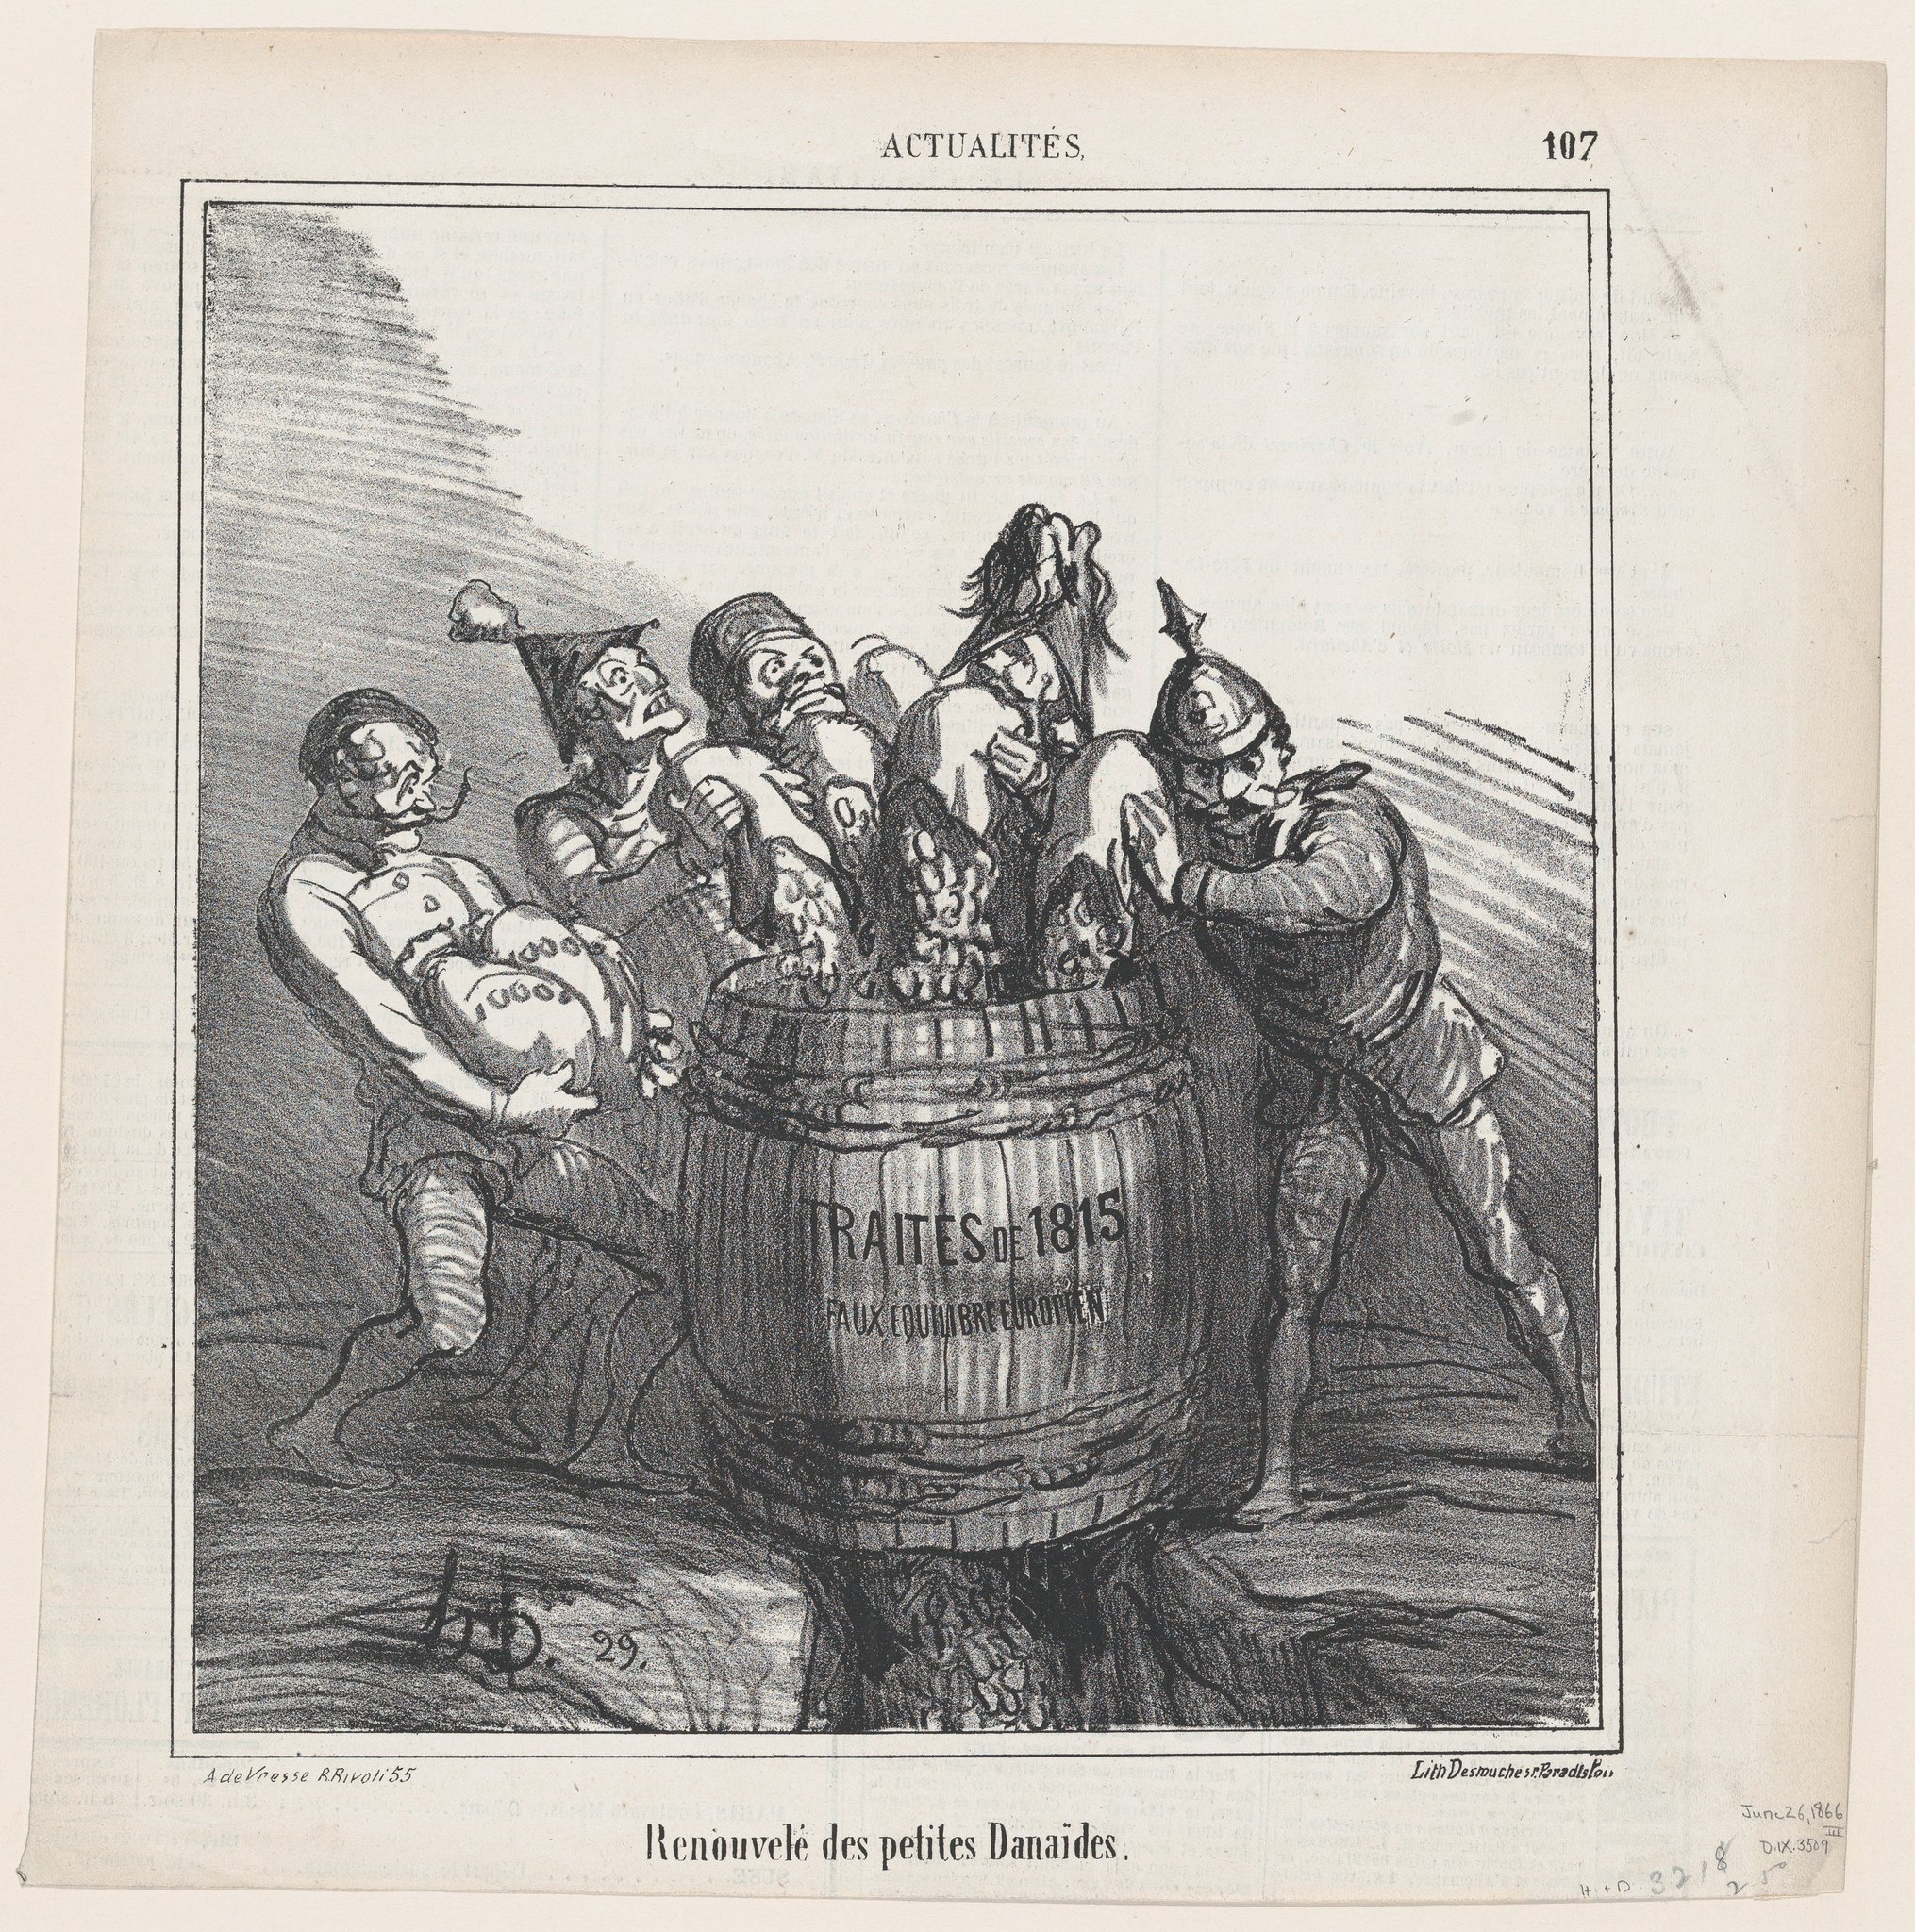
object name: print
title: Revival of the little Danaides, from "News of the day"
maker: honoré daumier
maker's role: artist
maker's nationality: french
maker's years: 1808-1879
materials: paper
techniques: lithograph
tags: satire,men